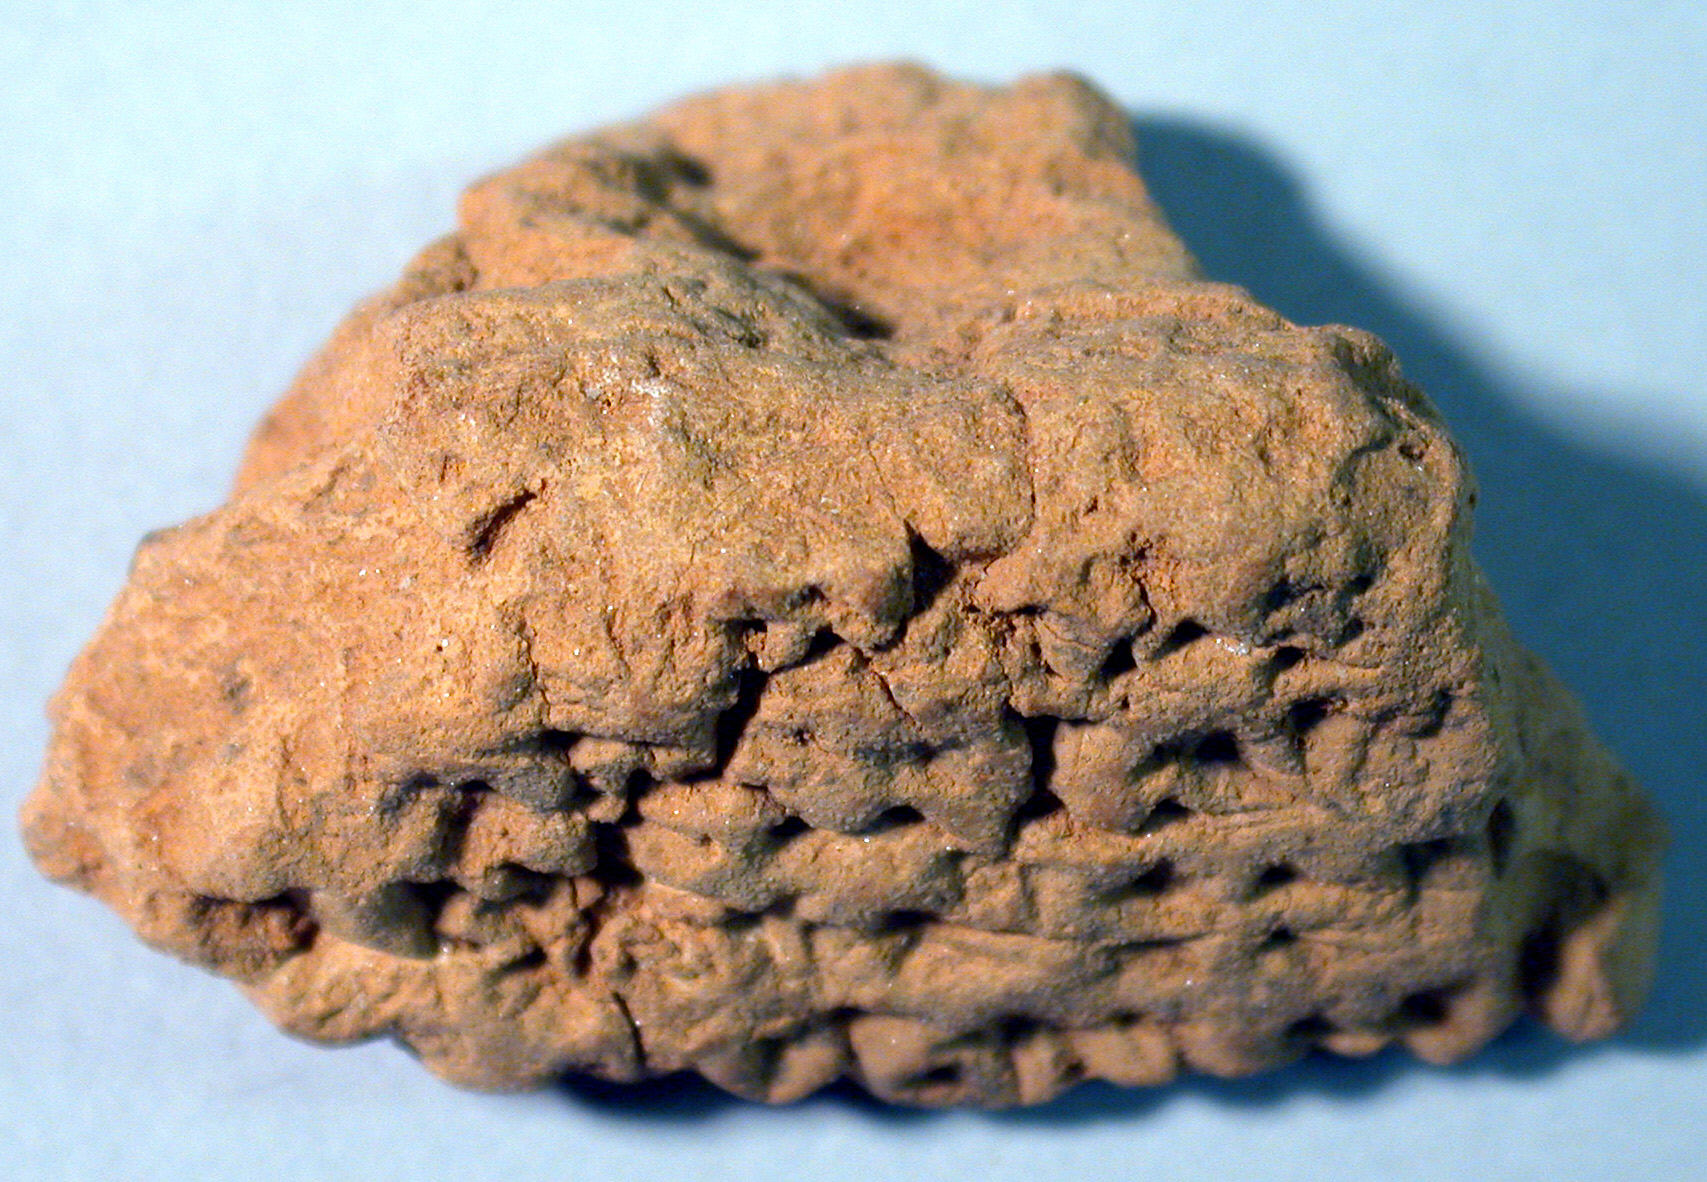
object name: cuneiform tablet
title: Cuneiform tablet: fragment, Ebabbar archive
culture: achaemenid or babylonian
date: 700-301 BCE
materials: clay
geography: mesopotamia